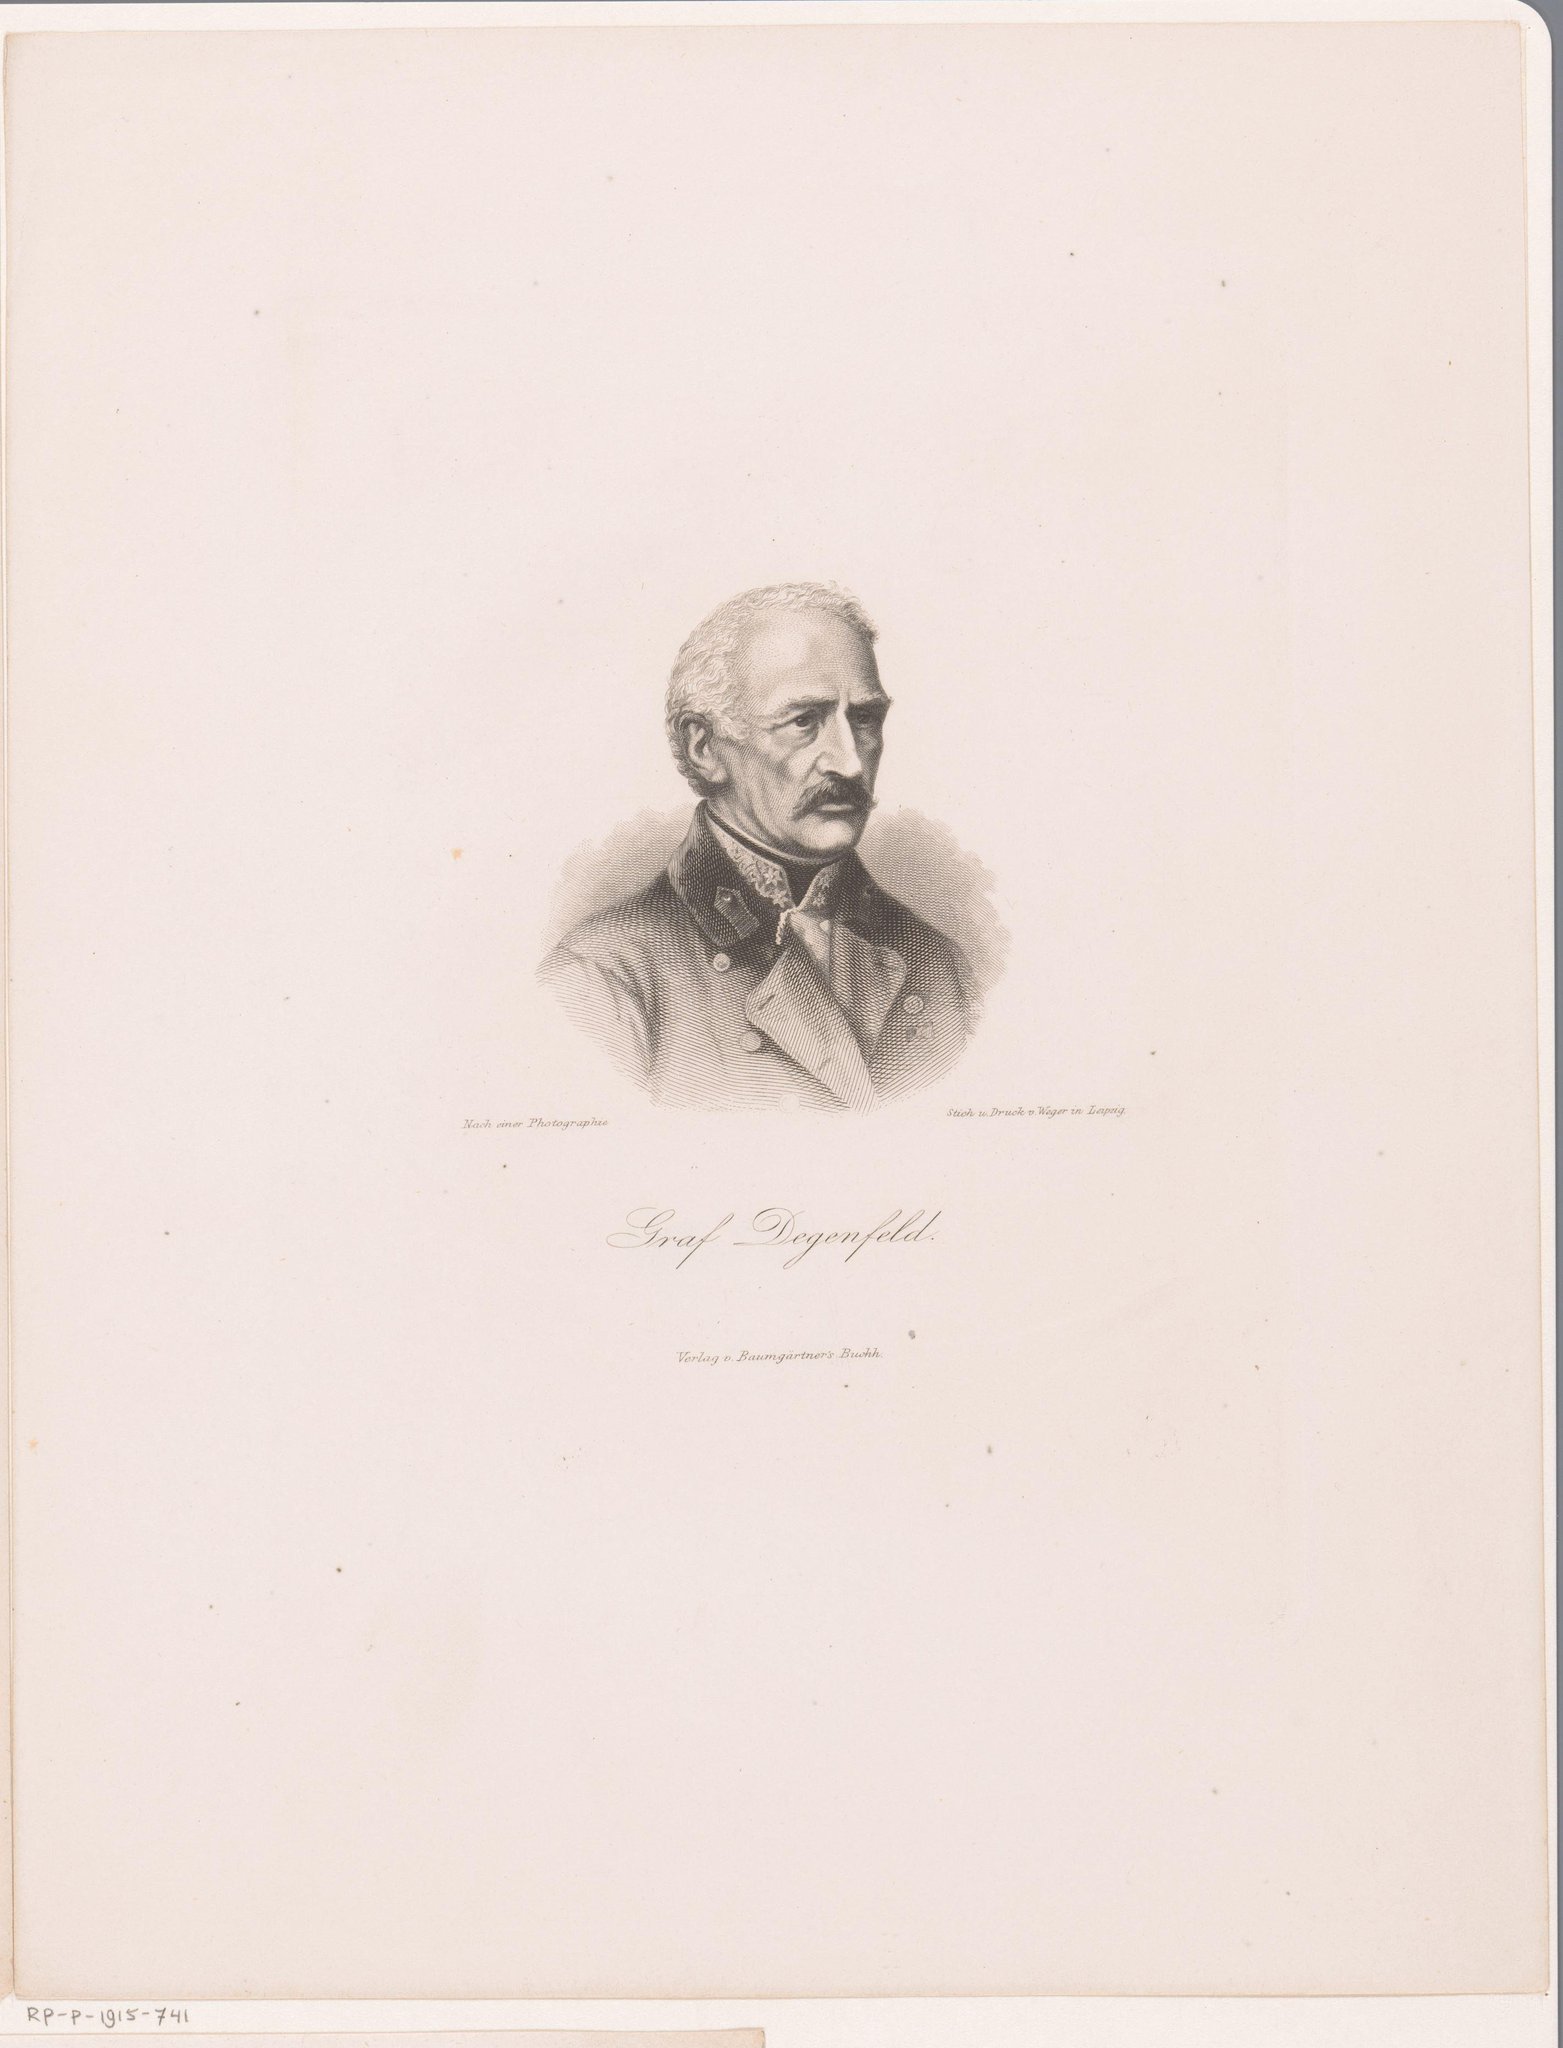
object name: print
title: Portret van August, Graf von Degenfeld-Schonburg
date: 1849-1892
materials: paper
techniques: engraving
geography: leipzig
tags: austria, earl, historical persons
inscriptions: collector's mark: Lugt 2228